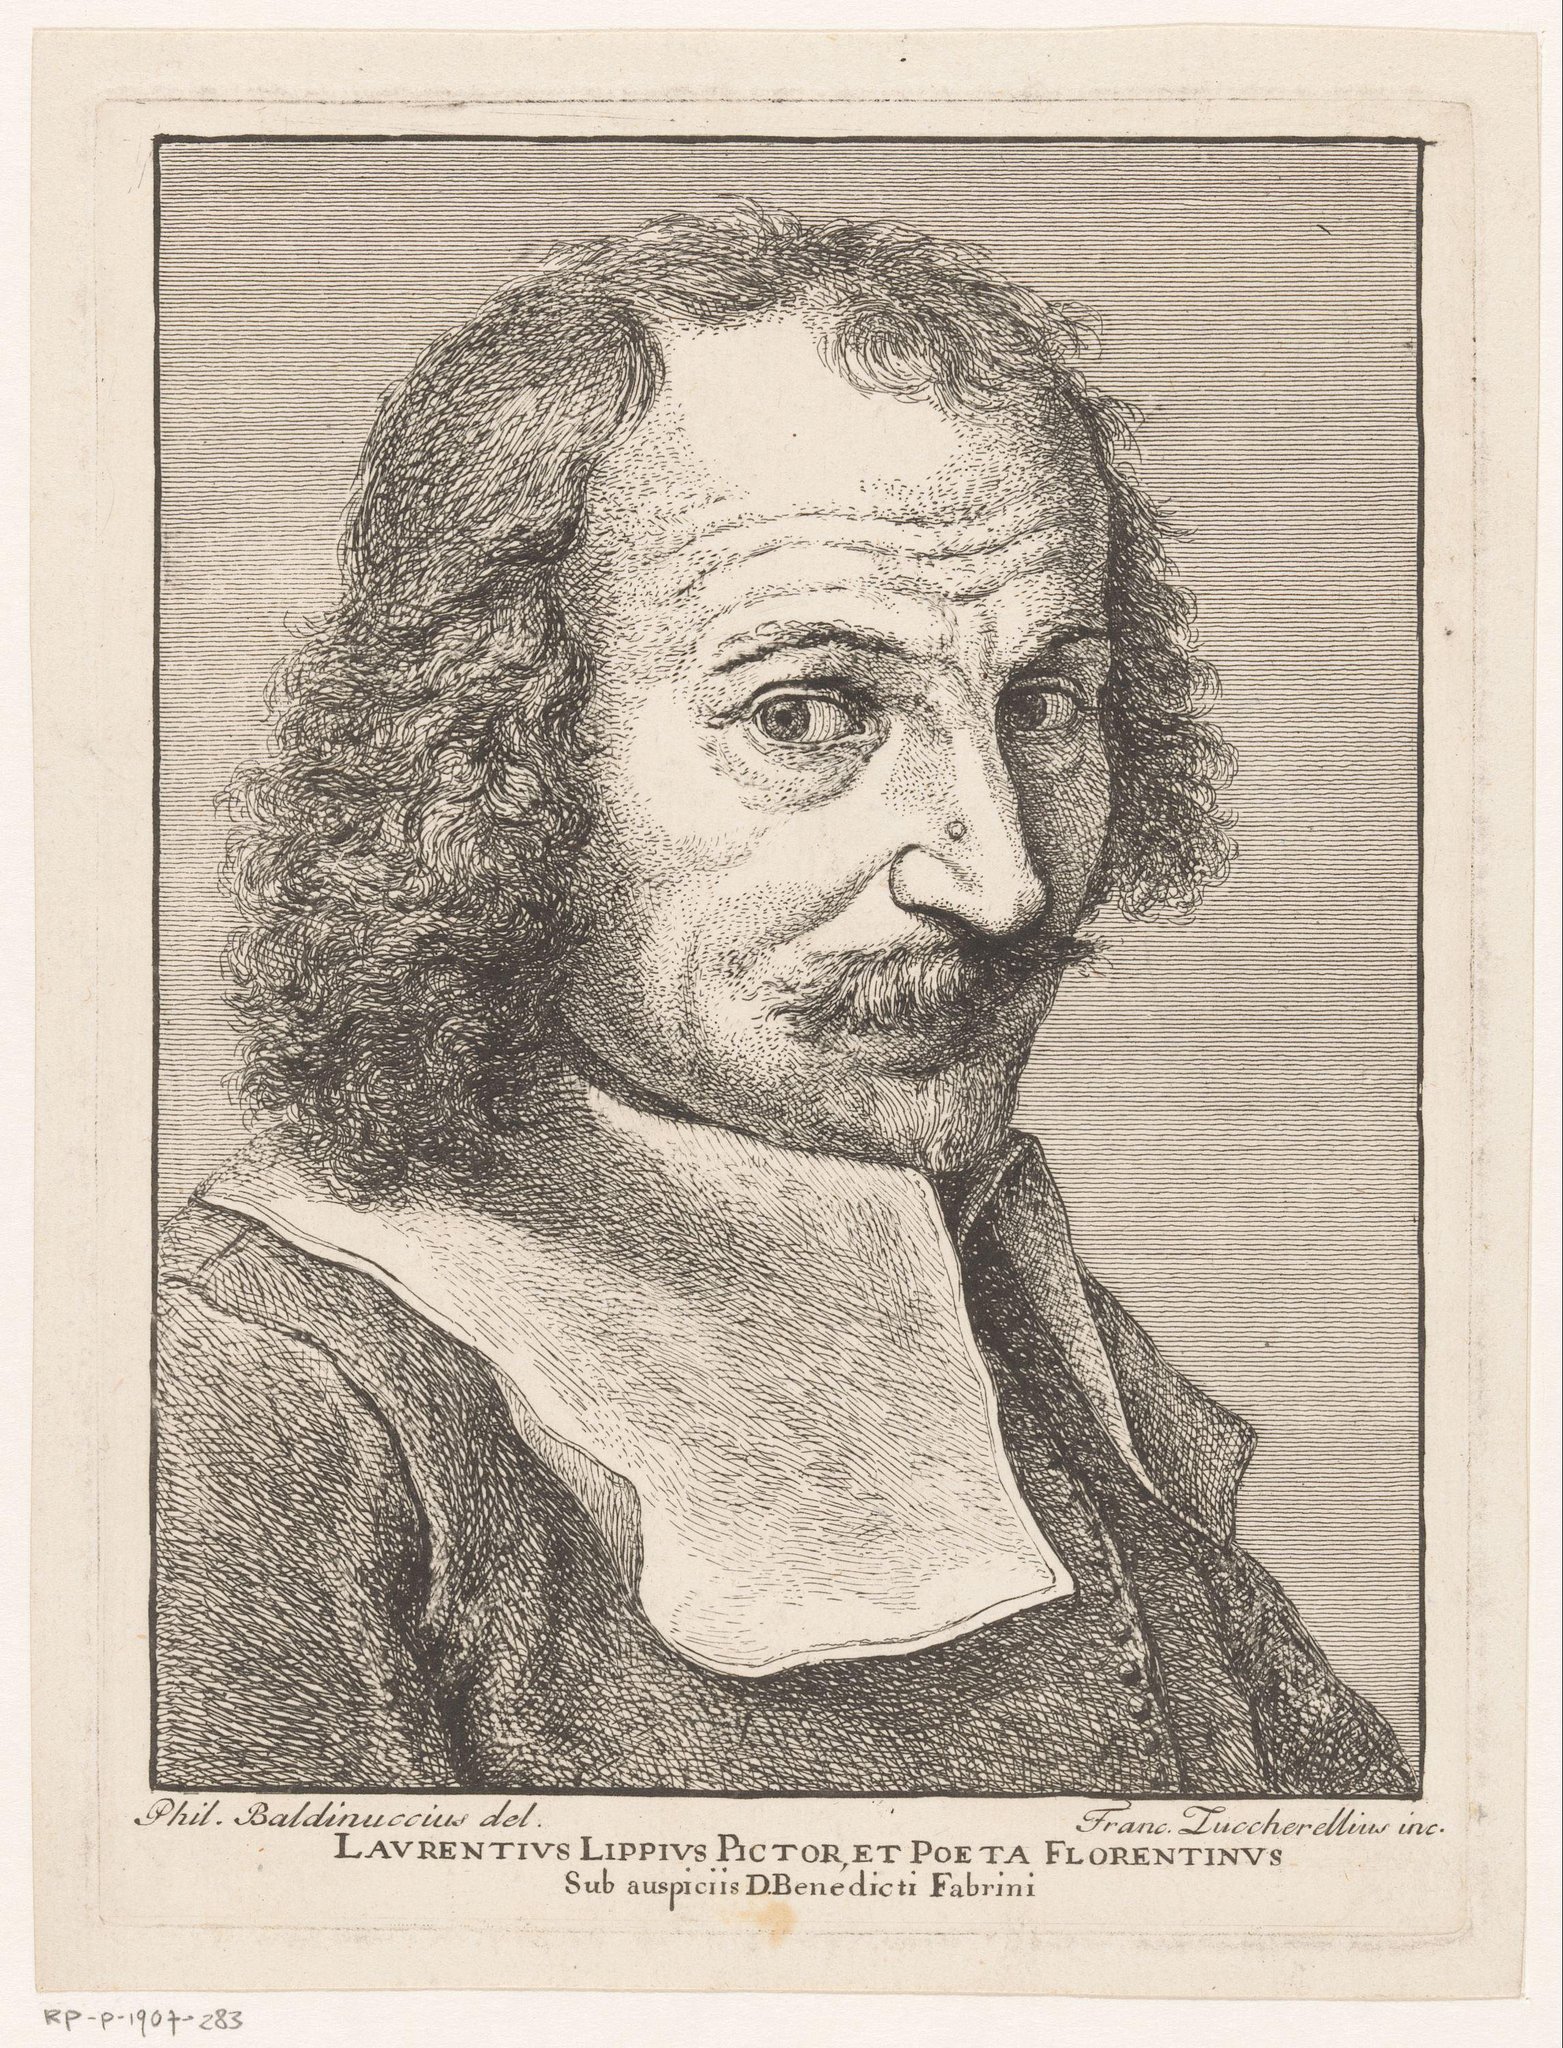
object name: print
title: Portret van schilder en dichter Lorenzo Lippi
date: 1712-1788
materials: paper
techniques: etching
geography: italy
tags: painter, historical persons, portrait, self-portrait of artist, writer, poet, author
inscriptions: collector's mark: Lugt 2228